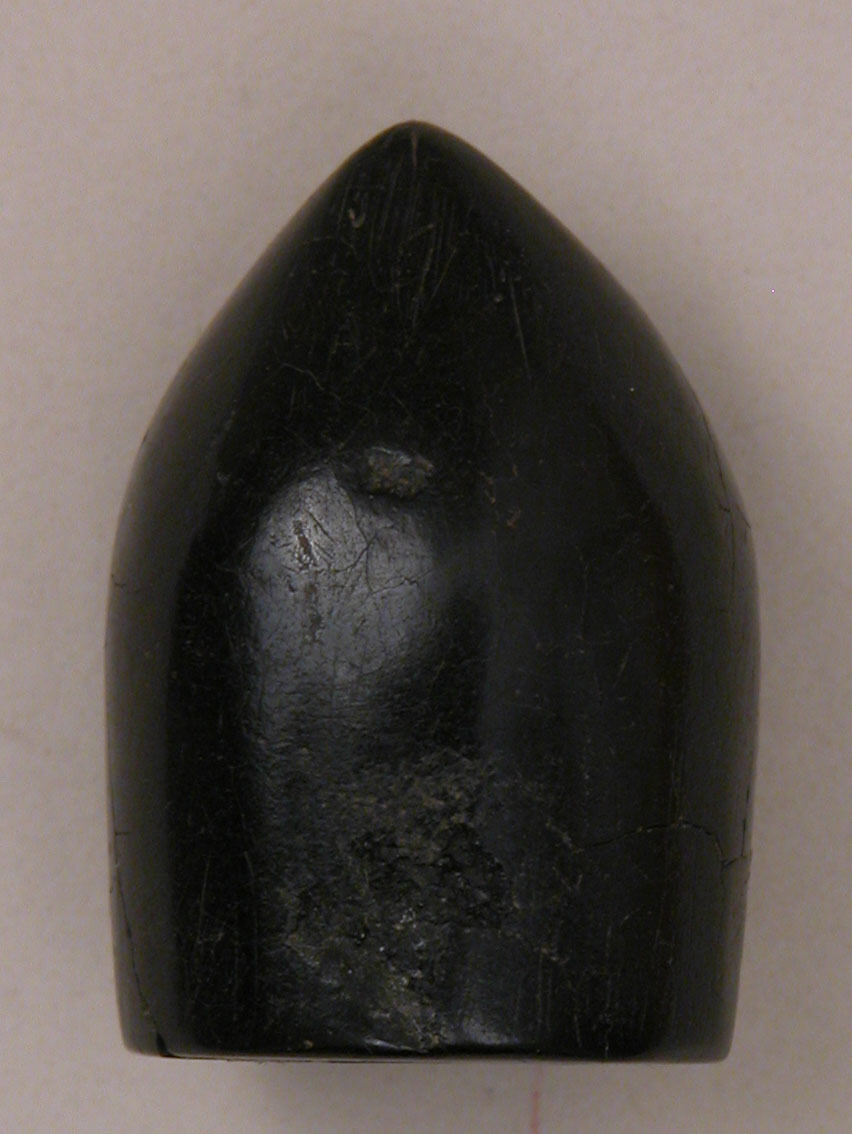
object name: chess piece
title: Chess Piece, probably a Pawn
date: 801-1100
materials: stone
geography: western islamic lands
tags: chess,games